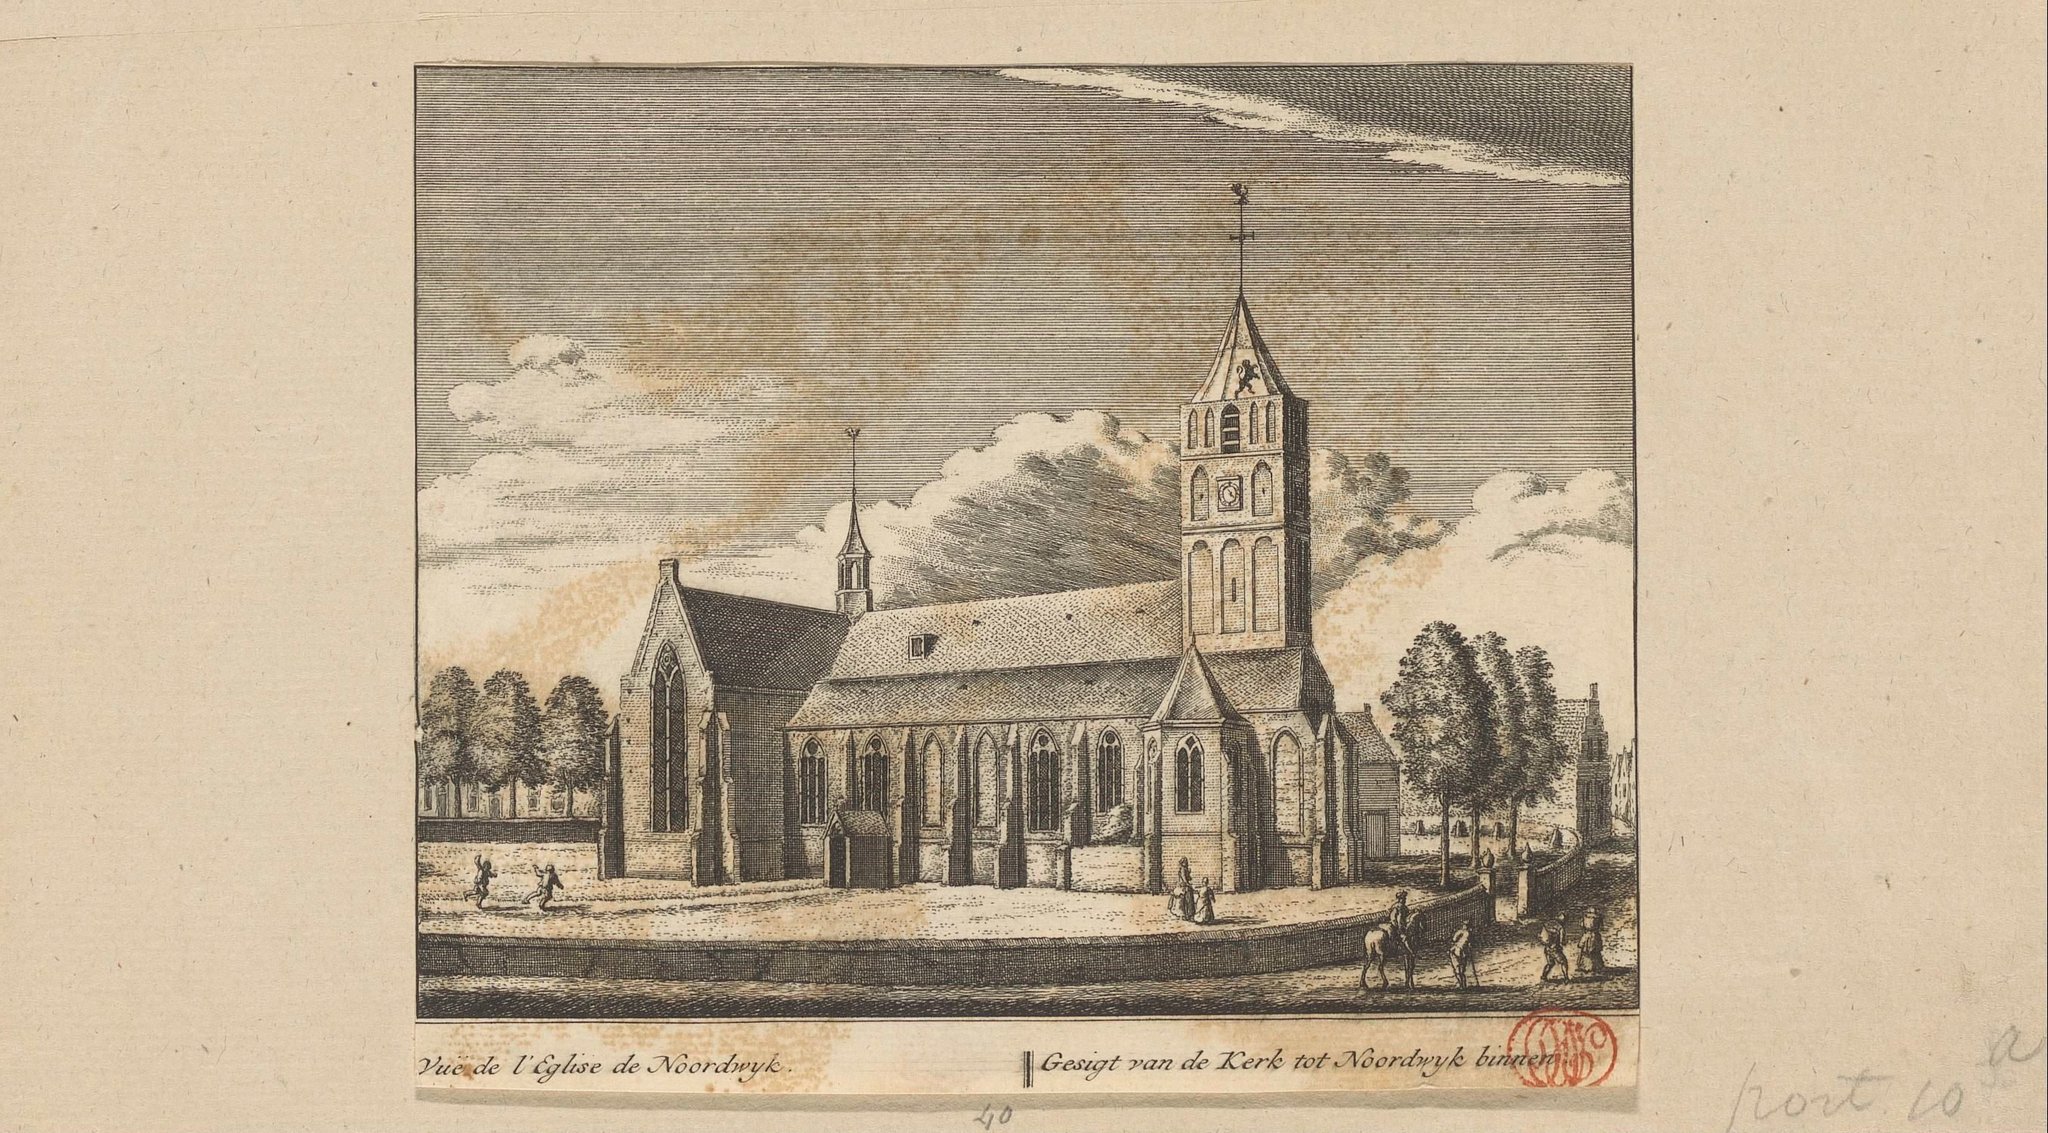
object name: book illustration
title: Gezicht op de kerk te Noordwijk-Binnen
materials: paper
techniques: etching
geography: amsterdam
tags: church (exterior), public road in village (+ city(-scape) with figures, staffage)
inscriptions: collector's mark: Lugt 195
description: Prent ook gebruikt in: Rademaker, Abraham. Rhynlands fraaiste gezichten; vertonende alle deszelfs lustplaatzen, heeren-huizen en dorpen. Van halfwegen Haarlem en Leyden (…) / Les plus agréables vuës de Rhynland, representant toutes les maisons de plaisance, maisons seigneuriales & villages. Commençant à demilieu Haarlem & Leyden (…). Ansterdam: Leonard Schenk, 1732.